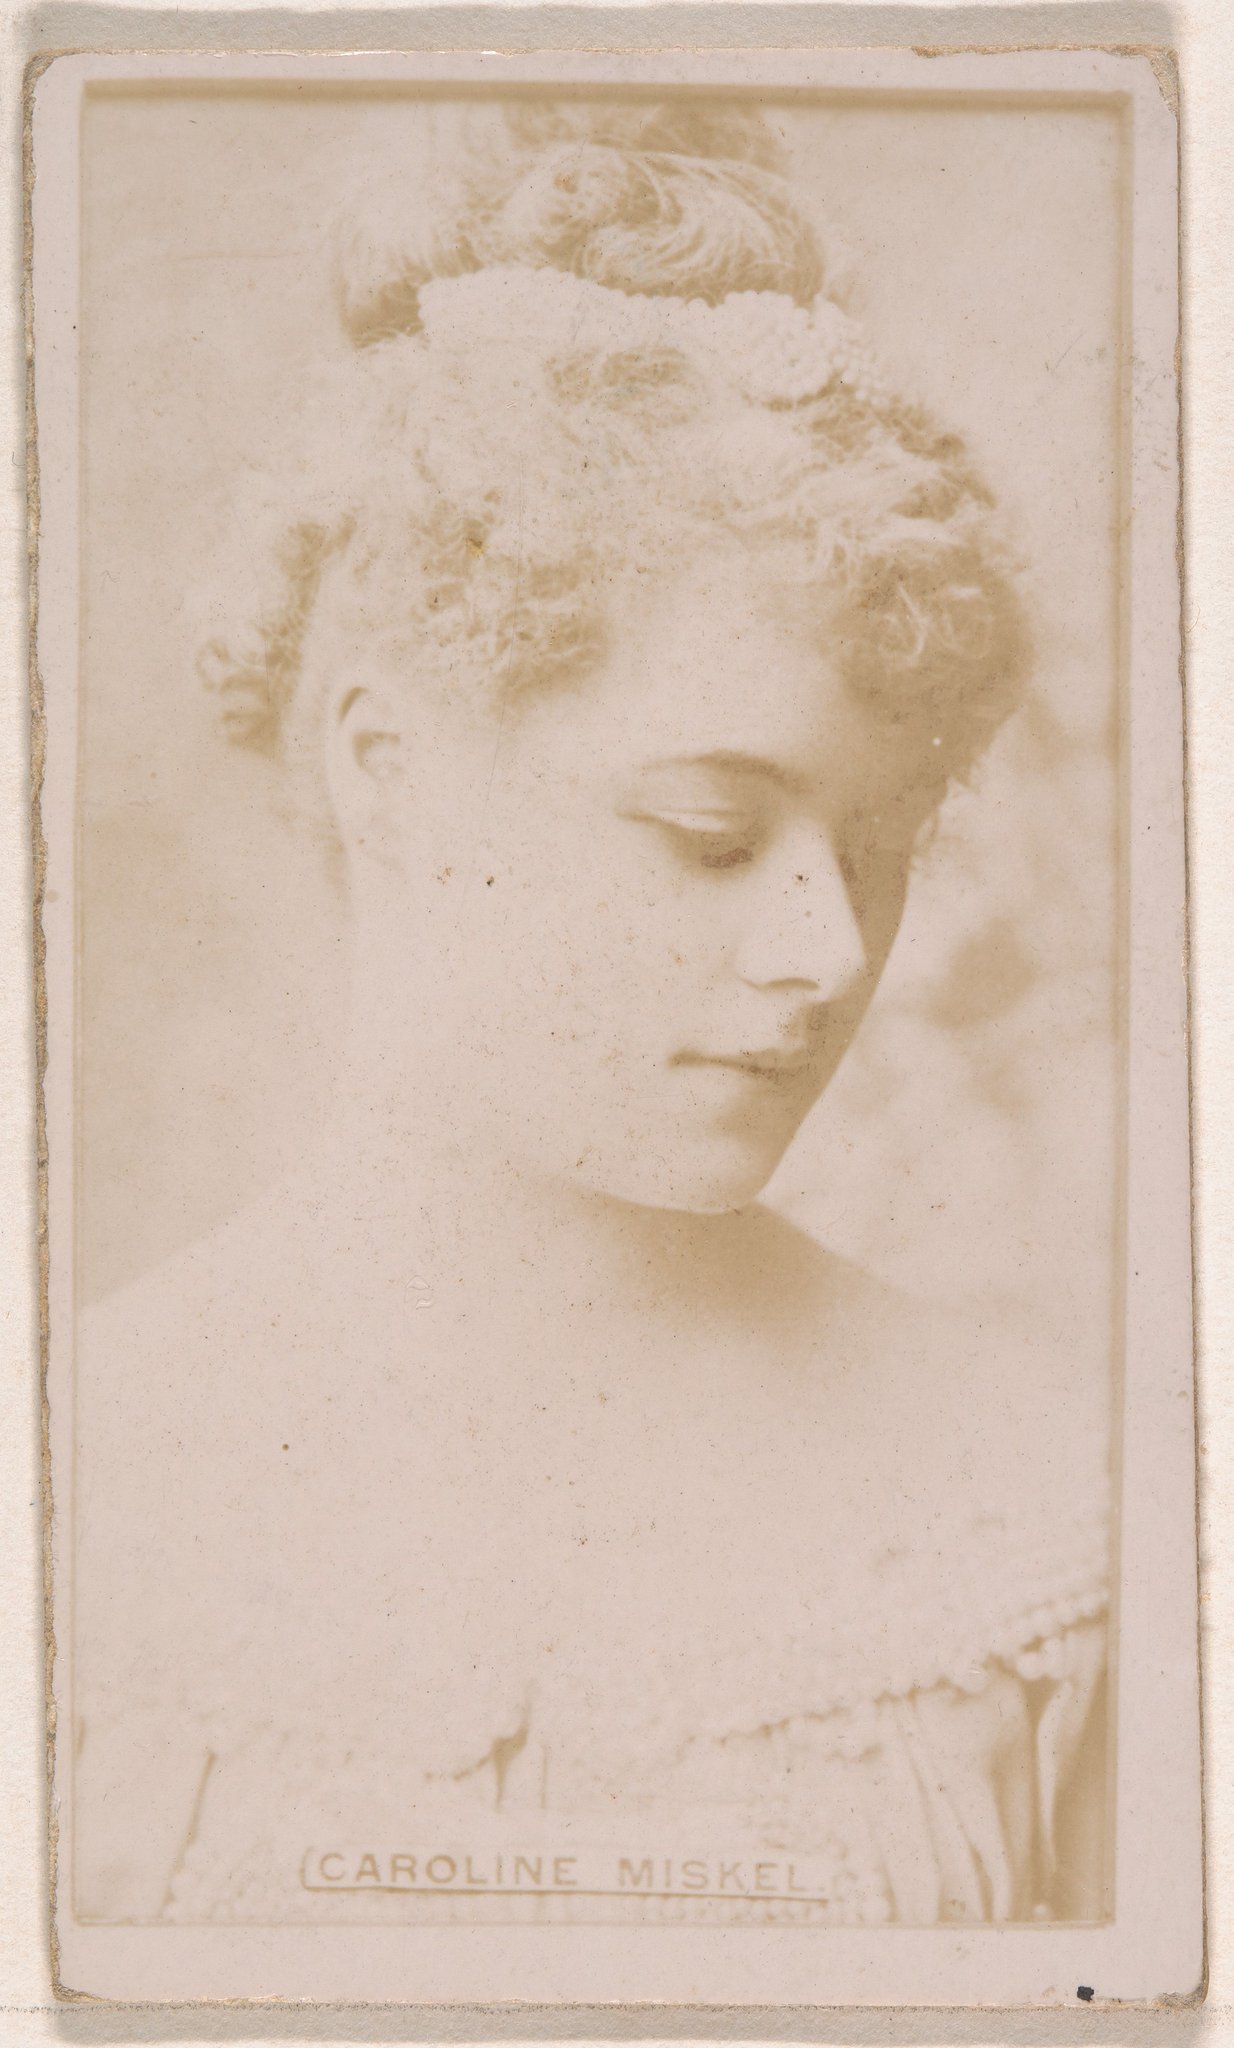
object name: photograph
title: Caroline Miskel, from the Actresses series (N245) issued by Kinney Brothers to promote Sweet Caporal Cigarettes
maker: kinney brothers tobacco company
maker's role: publisher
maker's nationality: american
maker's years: 1869-2011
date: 1890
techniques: albumen silver print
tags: portraits,women,actresses